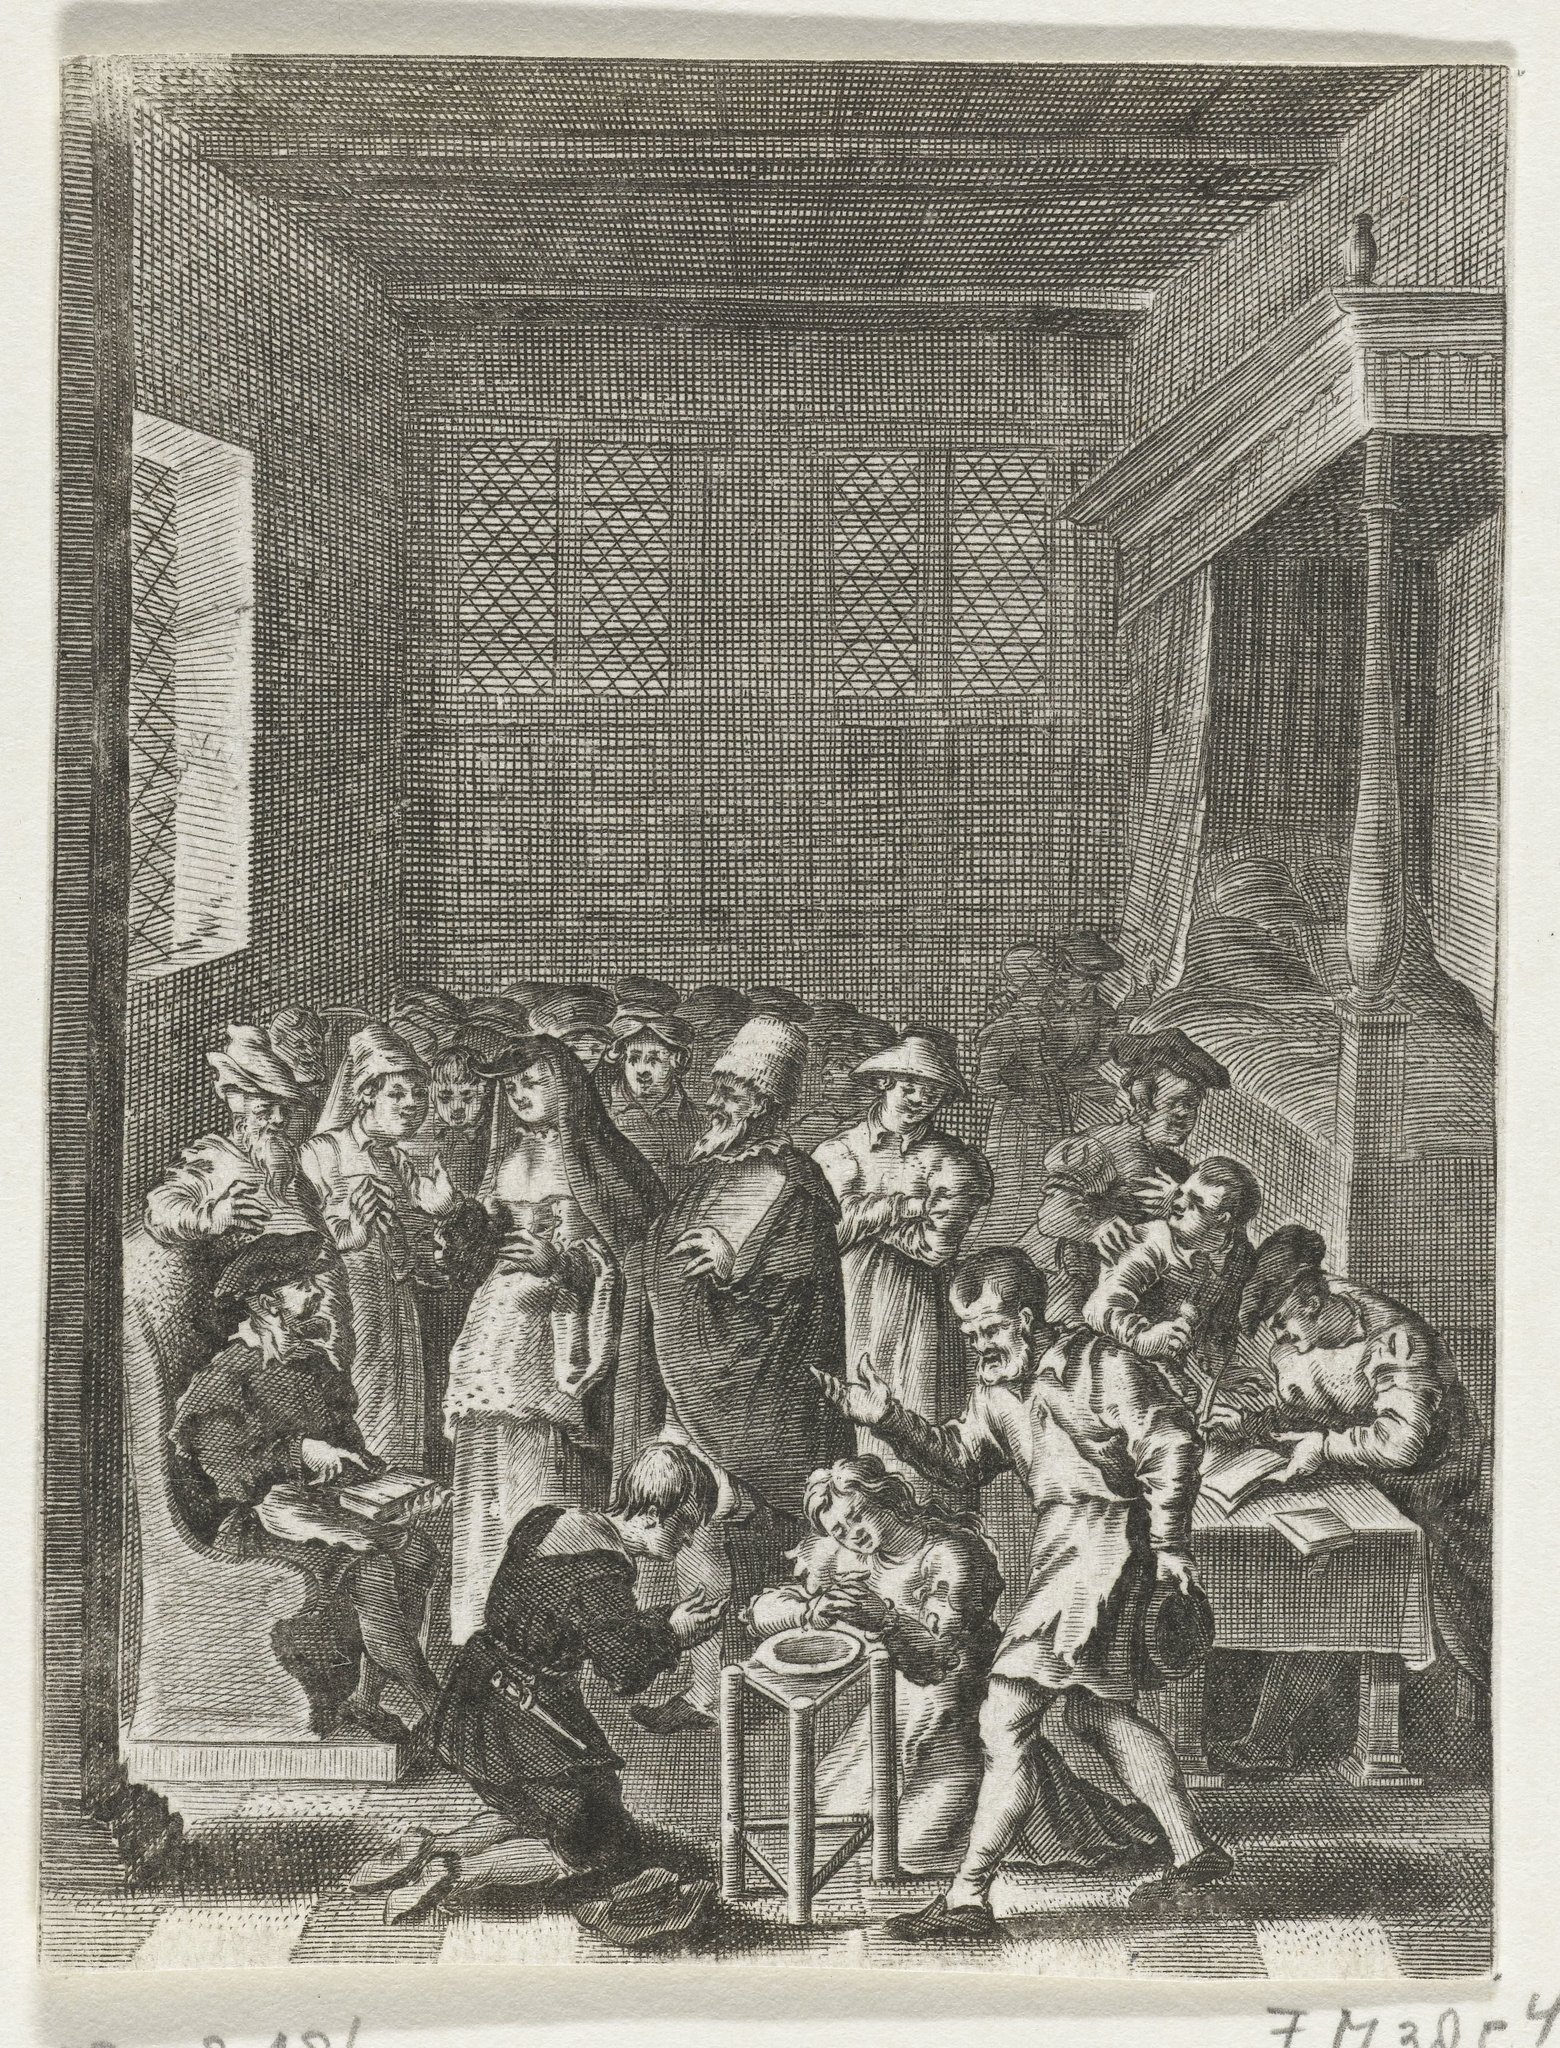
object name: print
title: Doop der wederdopers, 1535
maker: Anonymous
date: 1657-1659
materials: paper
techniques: engraving, etching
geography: northern netherlands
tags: baptism ~ protestant service, amsterdam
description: Illustratie voor: L. Hortensius, Het boeck D. Lamberti Hortensii (...). Van den oproer der weder-dooperen, J.J. Schipper, Amsterdam 1659. De prenten in deze uitgave zijn gekopieerd naar de anonieme gravures in de eerste uitgave van 1614. Naar het verloren gegane schilderij van Barend Dircksz. in het oude stadhuis te Amsterdam.